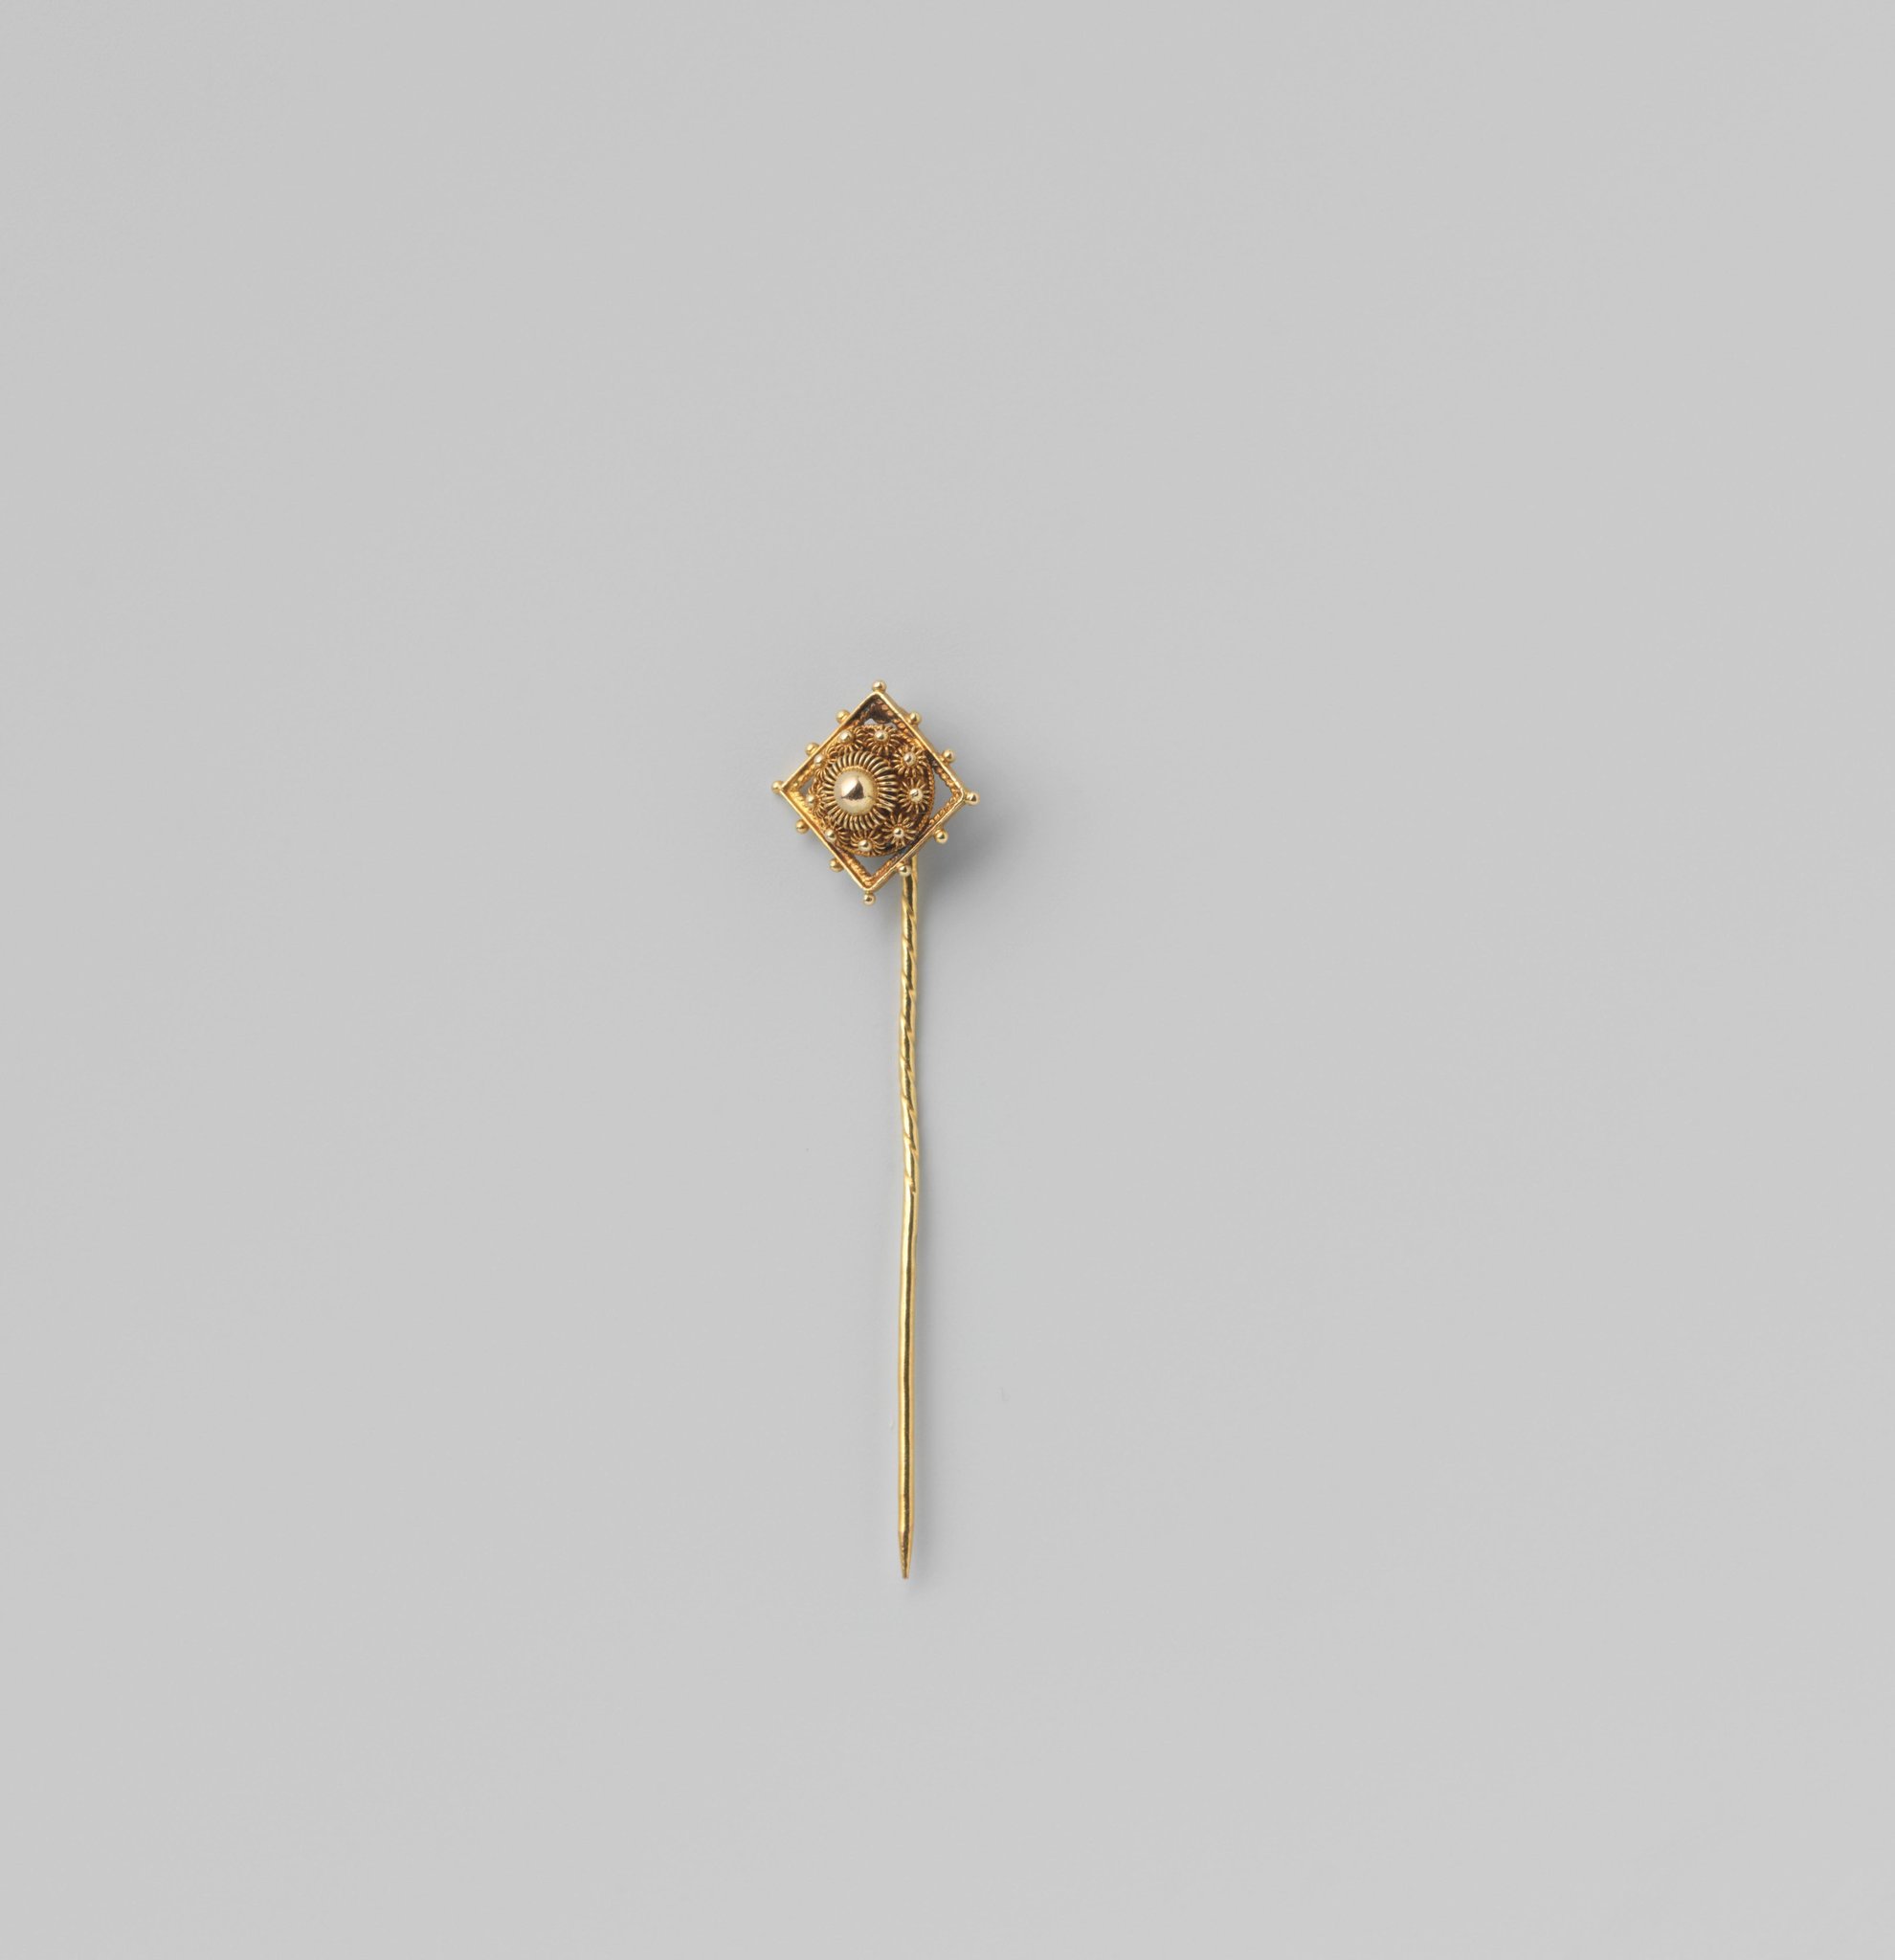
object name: lapel pin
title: Ruitvormige reversspeld van goud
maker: Anonymous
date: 1930-1940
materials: gold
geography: netherlands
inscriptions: alloy mark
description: Ruitvormige reversspeld van goud met spinnetjes. In een ruit is een Zeeuwse knop geplaatst. De buitenkant van de ruit is gedecoreerd met twaalf gouden bolletjes.